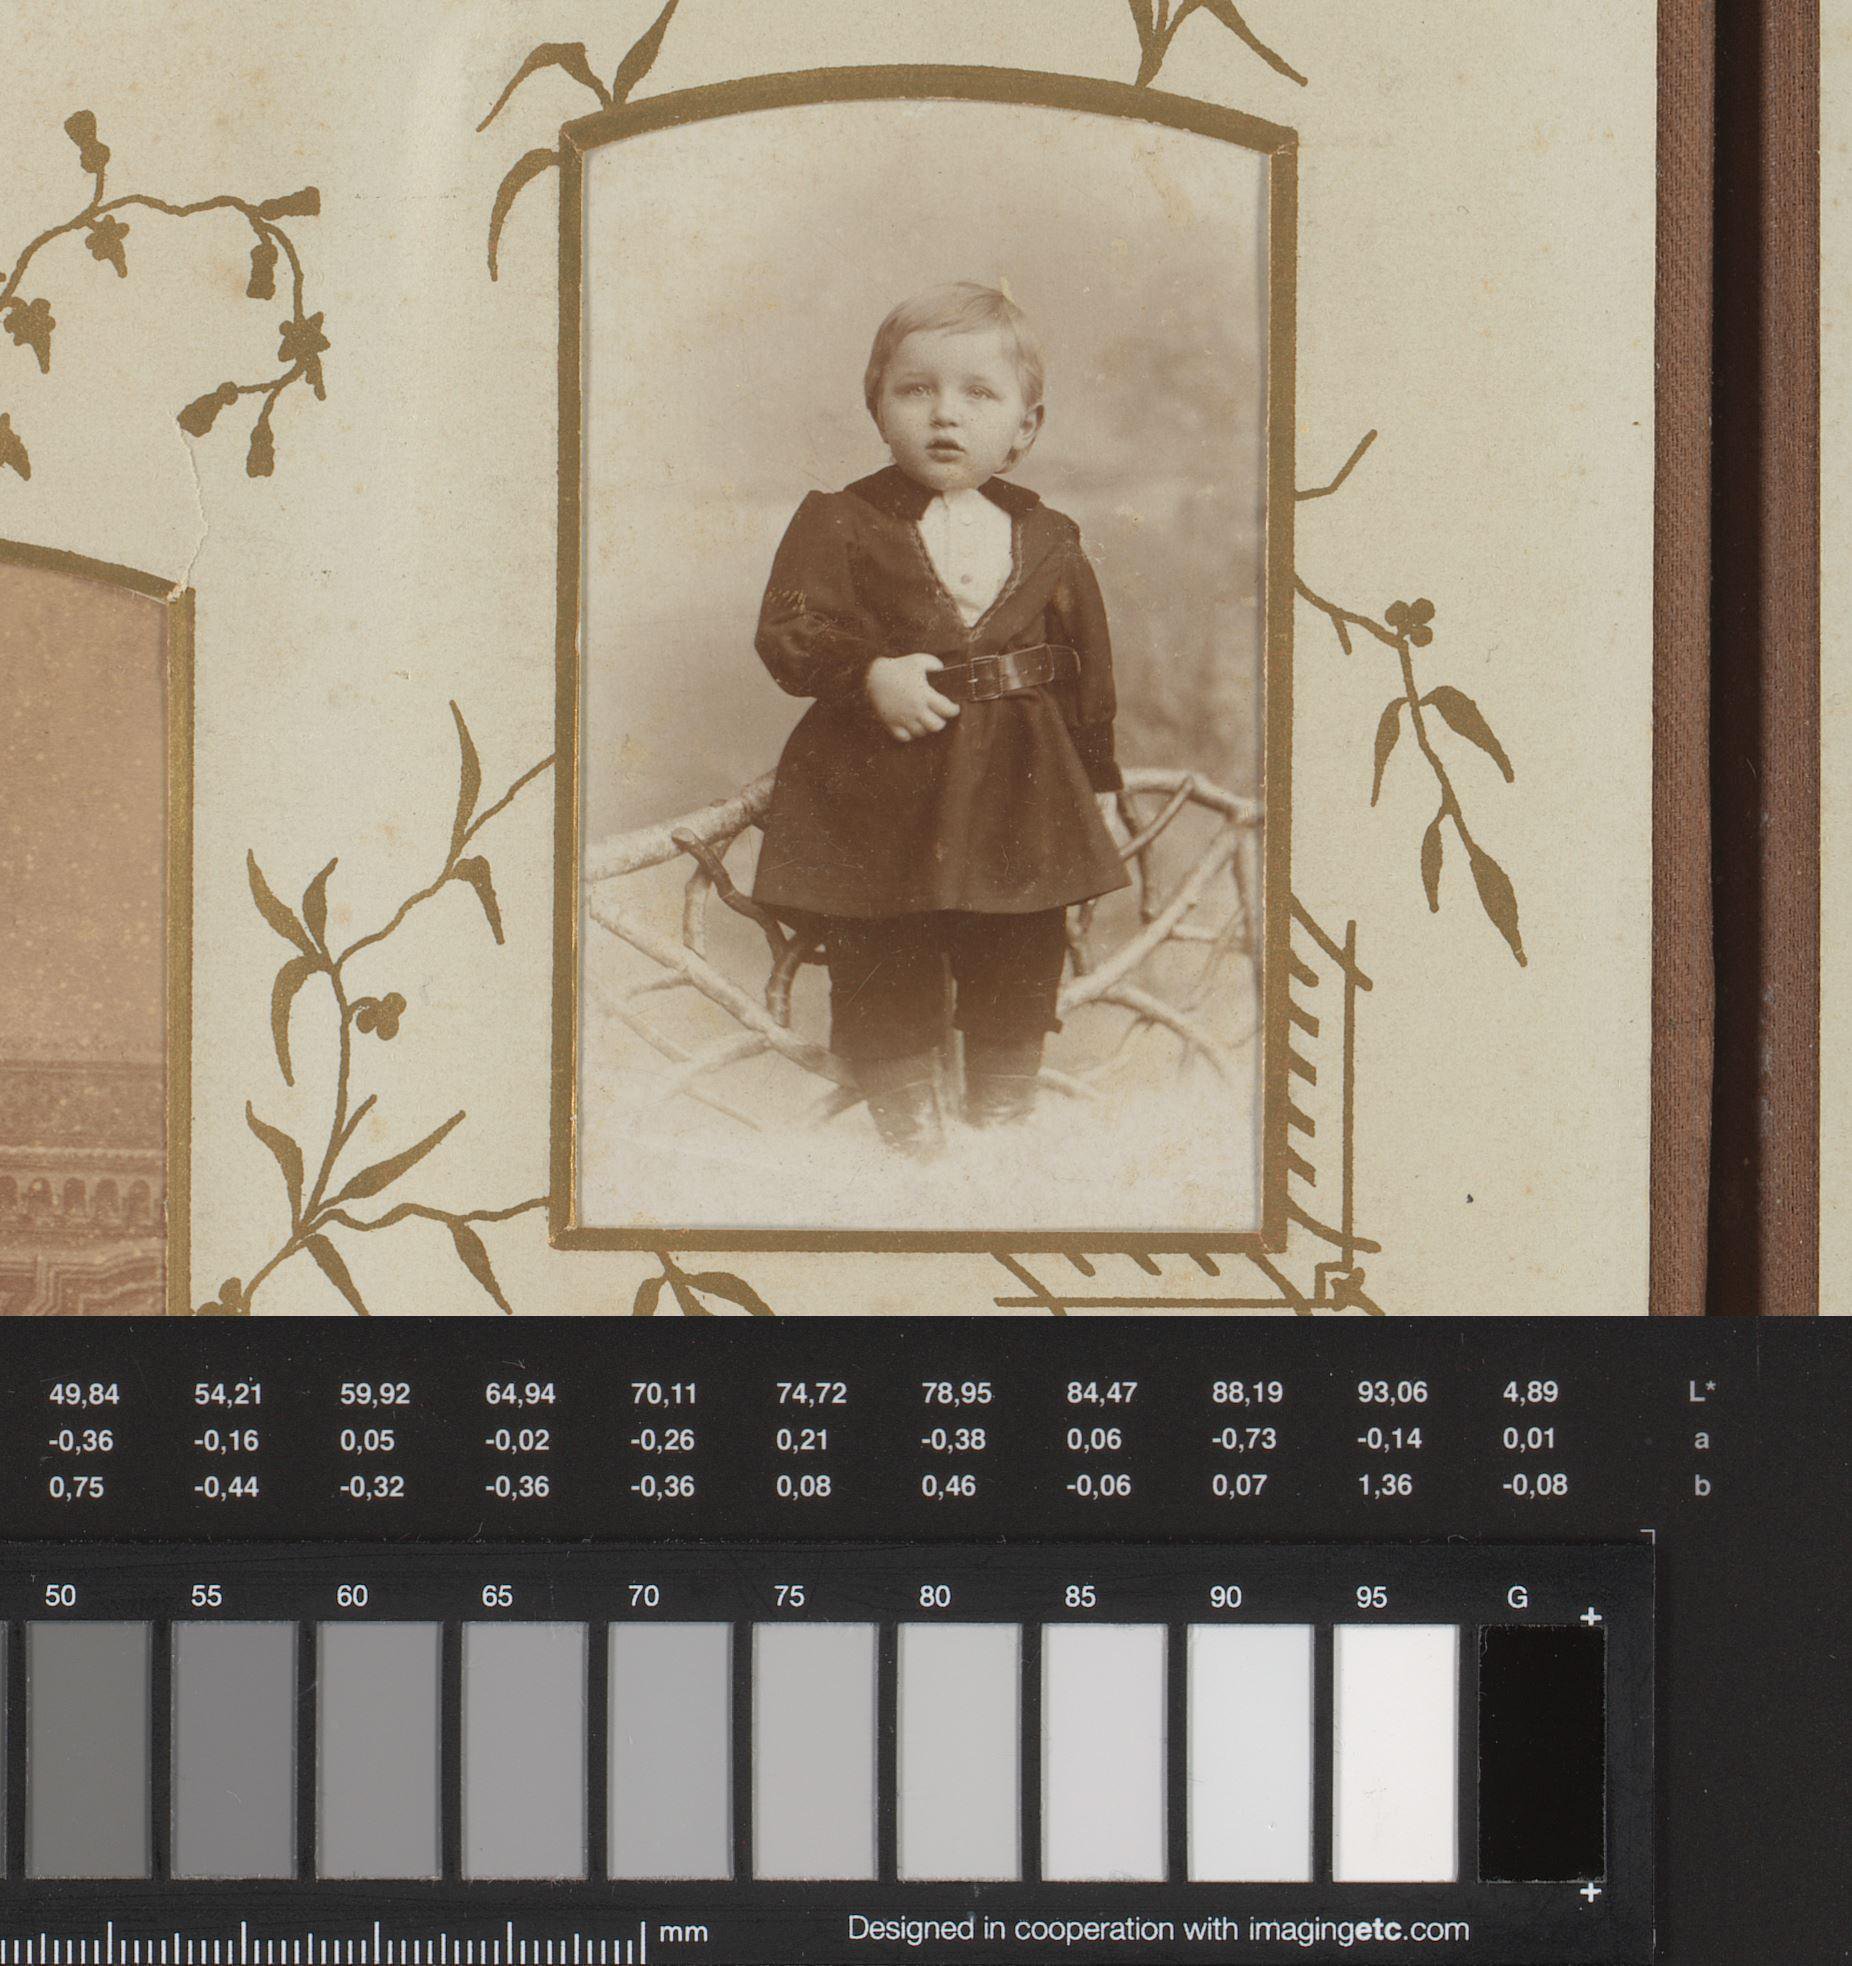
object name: photograph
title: Portret van een kind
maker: Anonymous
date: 1860-1900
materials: cardboard, photographic support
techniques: albumen print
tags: child, historical persons